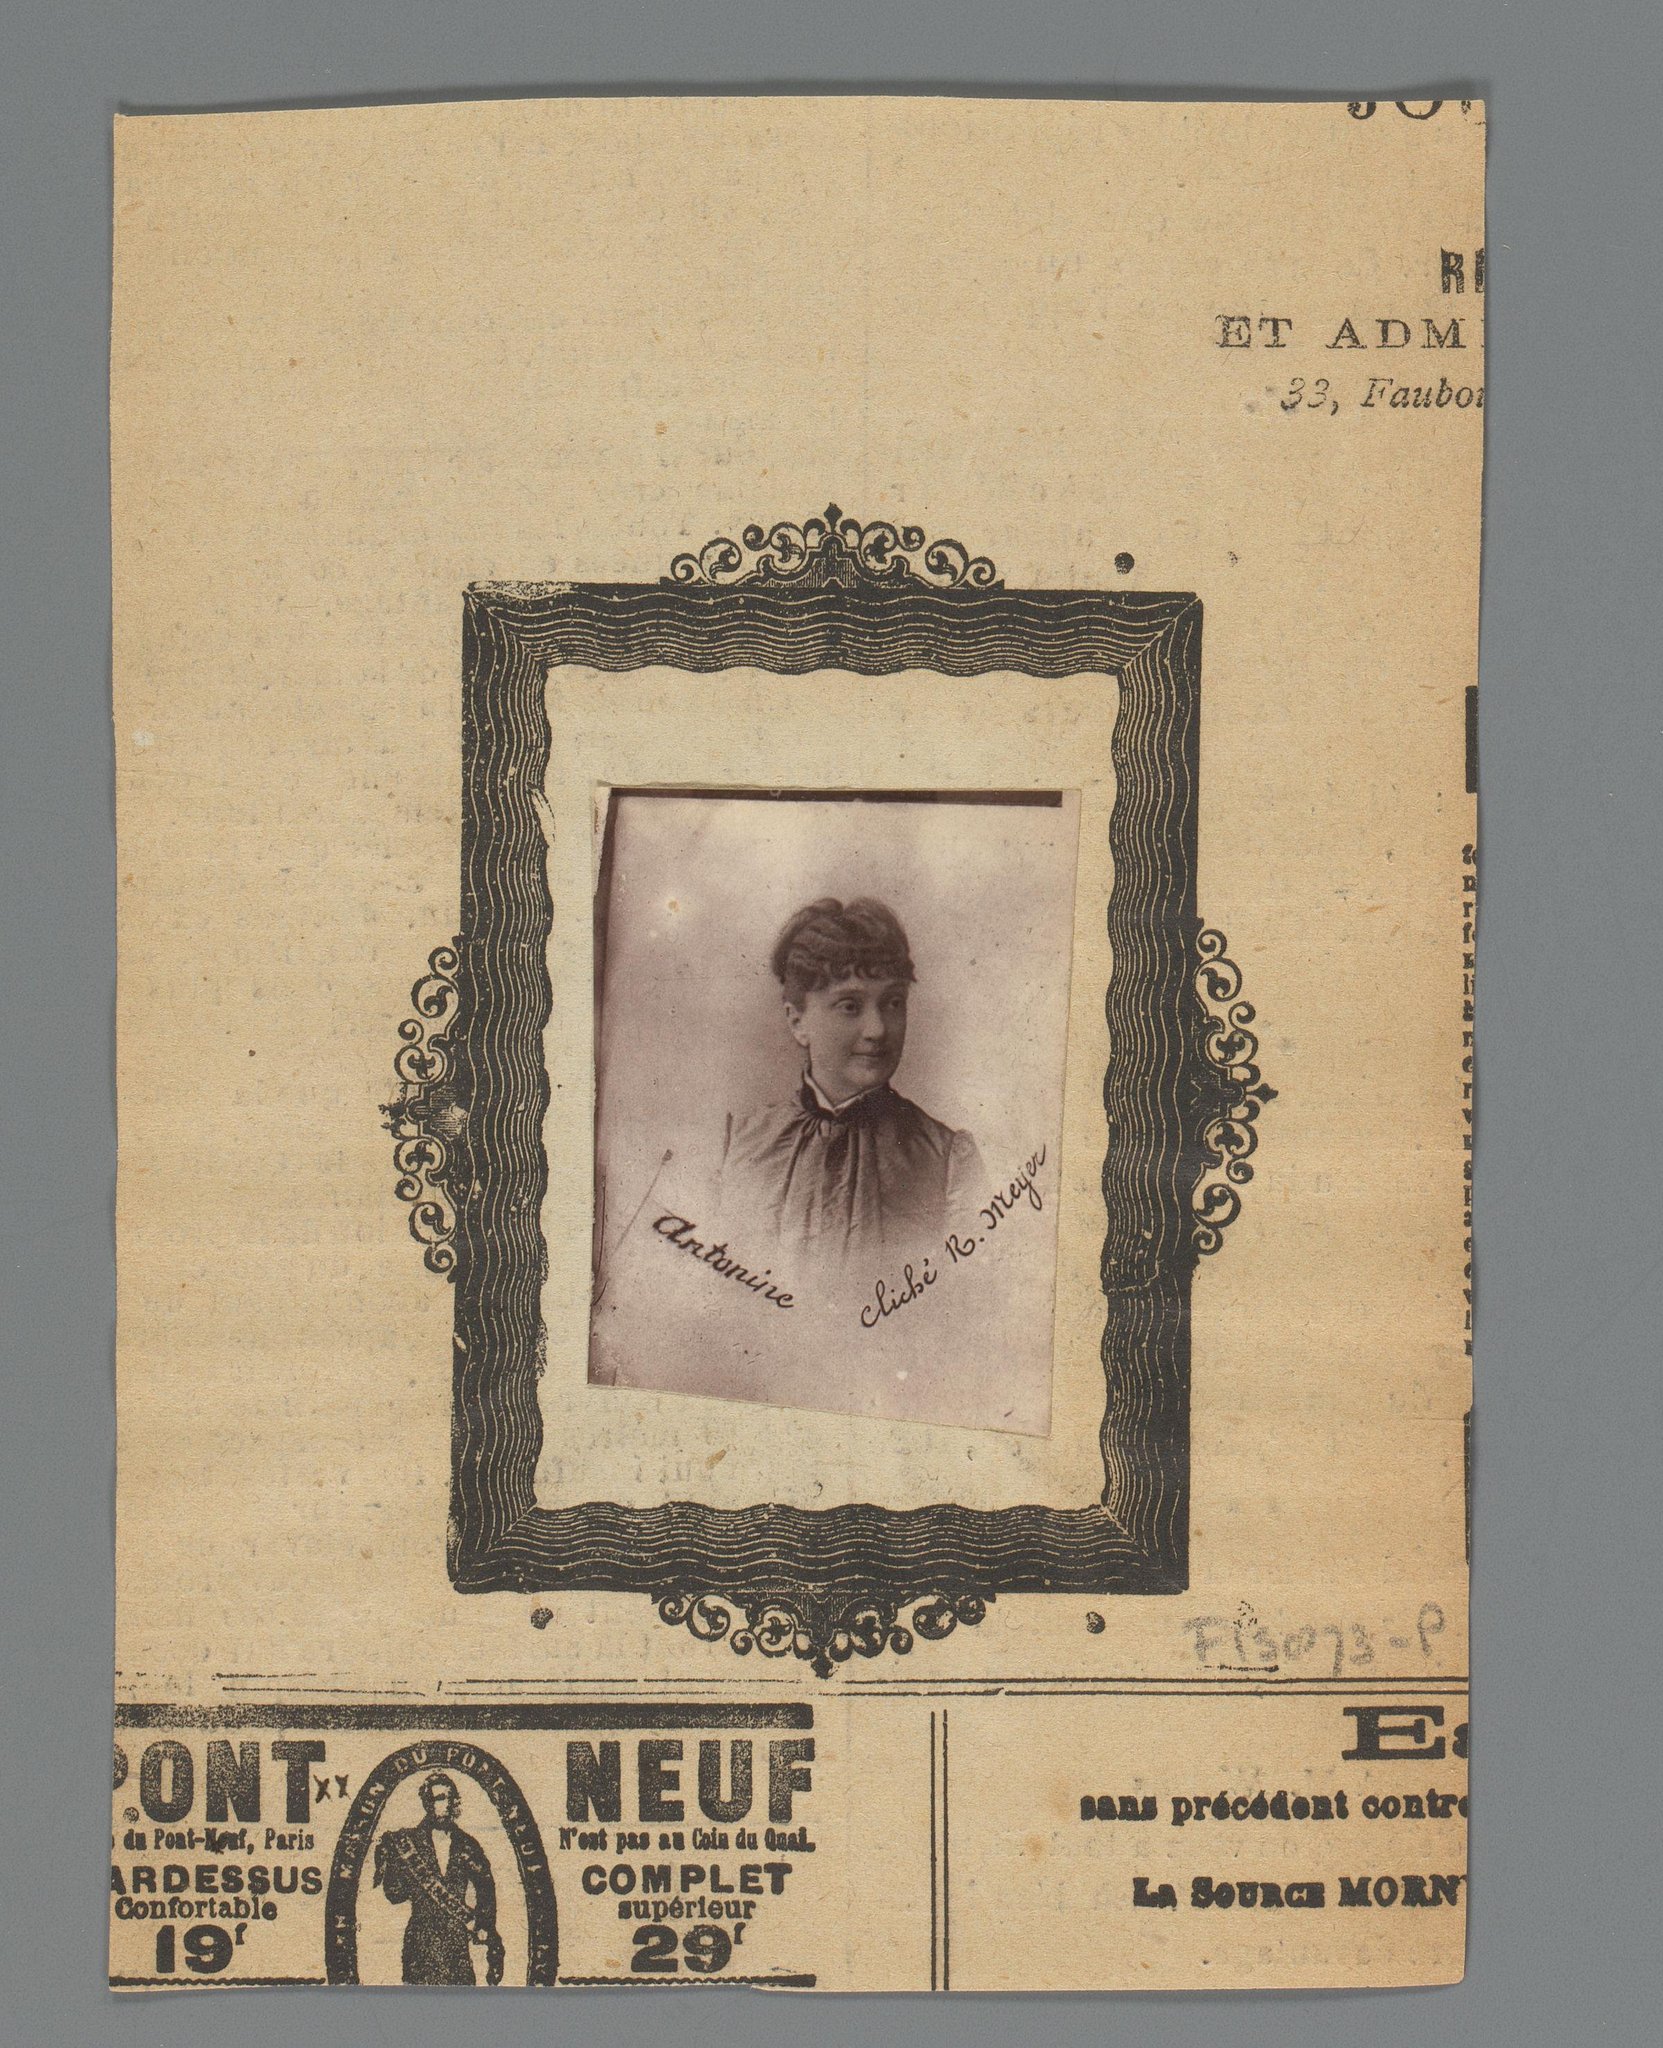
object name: photograph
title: Portret van de actrice Antonine Pélissié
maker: r. meijer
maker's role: fotograaf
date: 1890-1910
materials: paper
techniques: albumen print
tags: portrait of actor, actress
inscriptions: inscription: ‘Antonine/ cliché R. Meijer’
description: Knipsel uit 'Les Folies-Bergèr, journal spécial au théâtre' met een opgeplakt fotoportret.